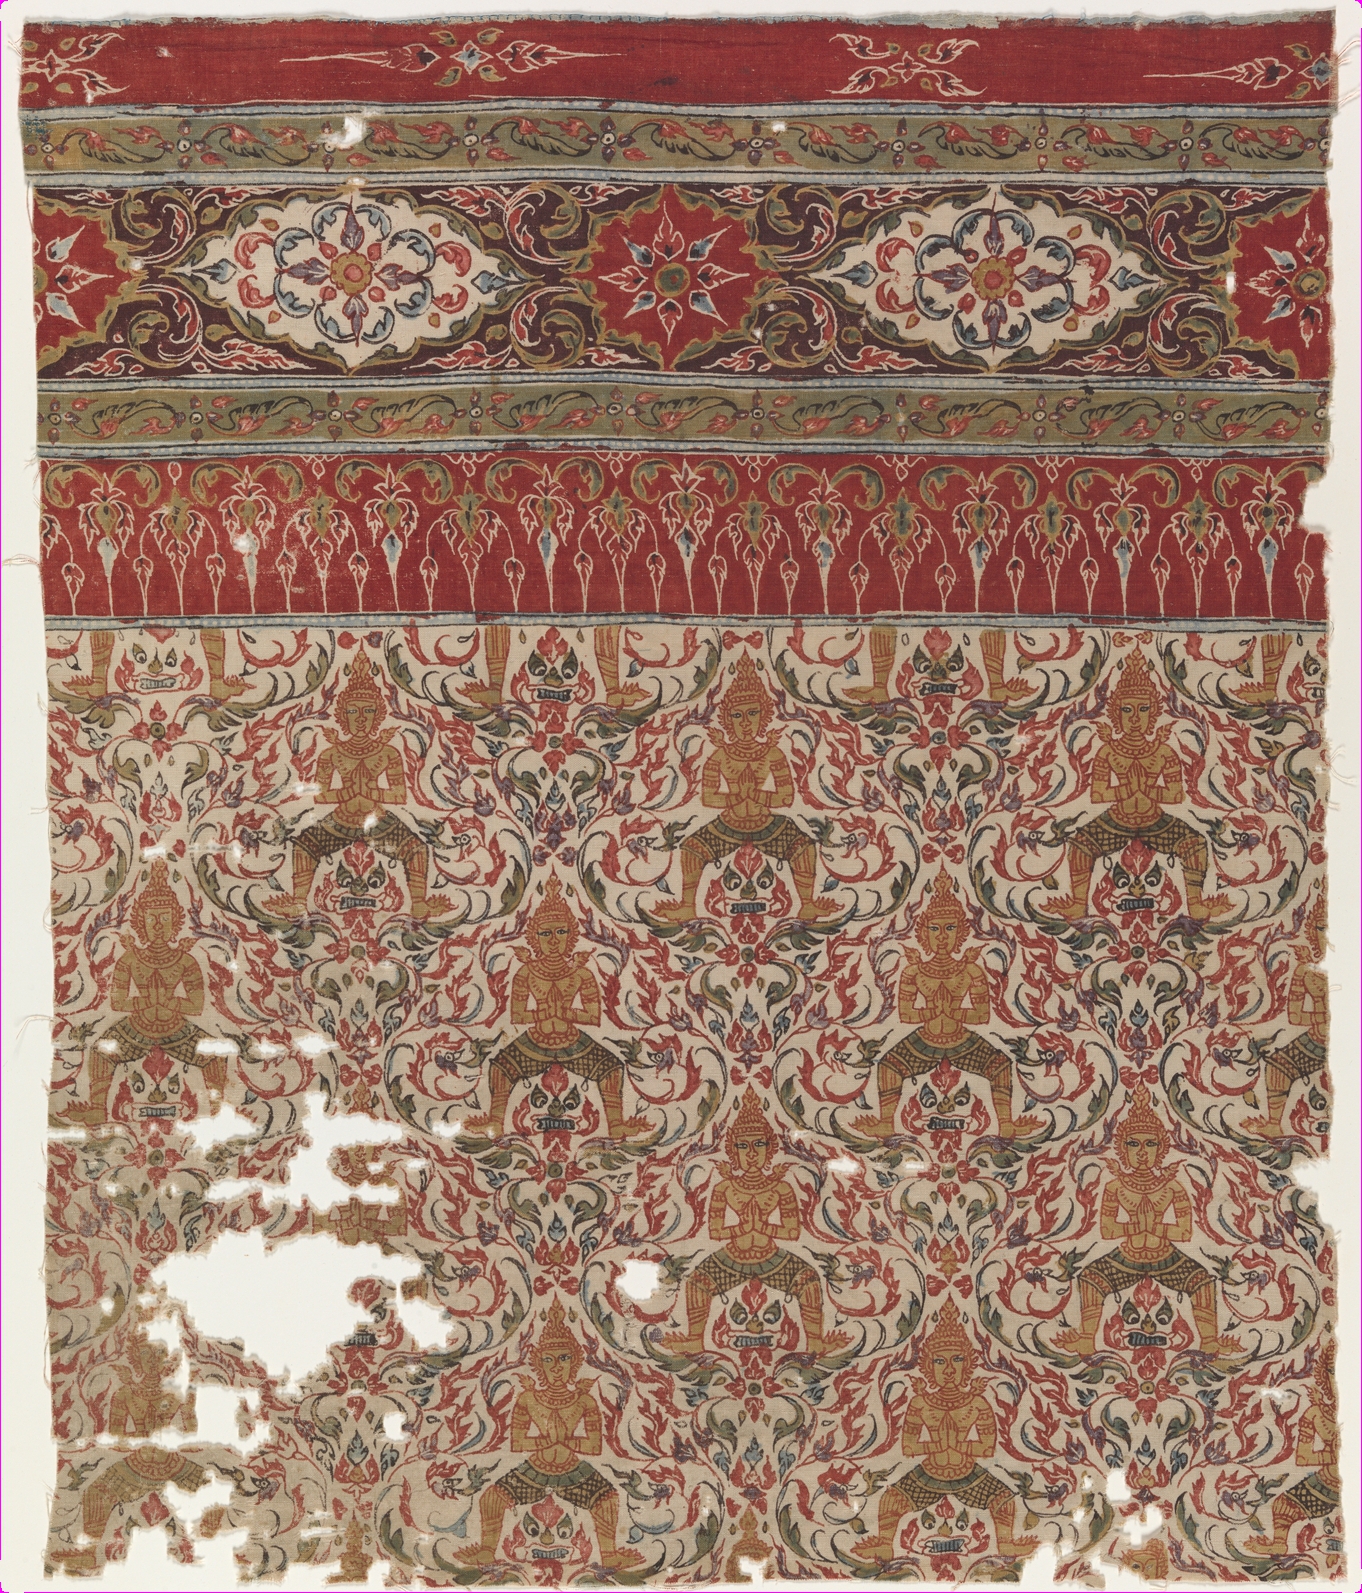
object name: textile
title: Pha-nung with Celestial Worshippers Design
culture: indian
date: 1701-1800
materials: cotton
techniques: drawing, dyeing, painting, weave, resist